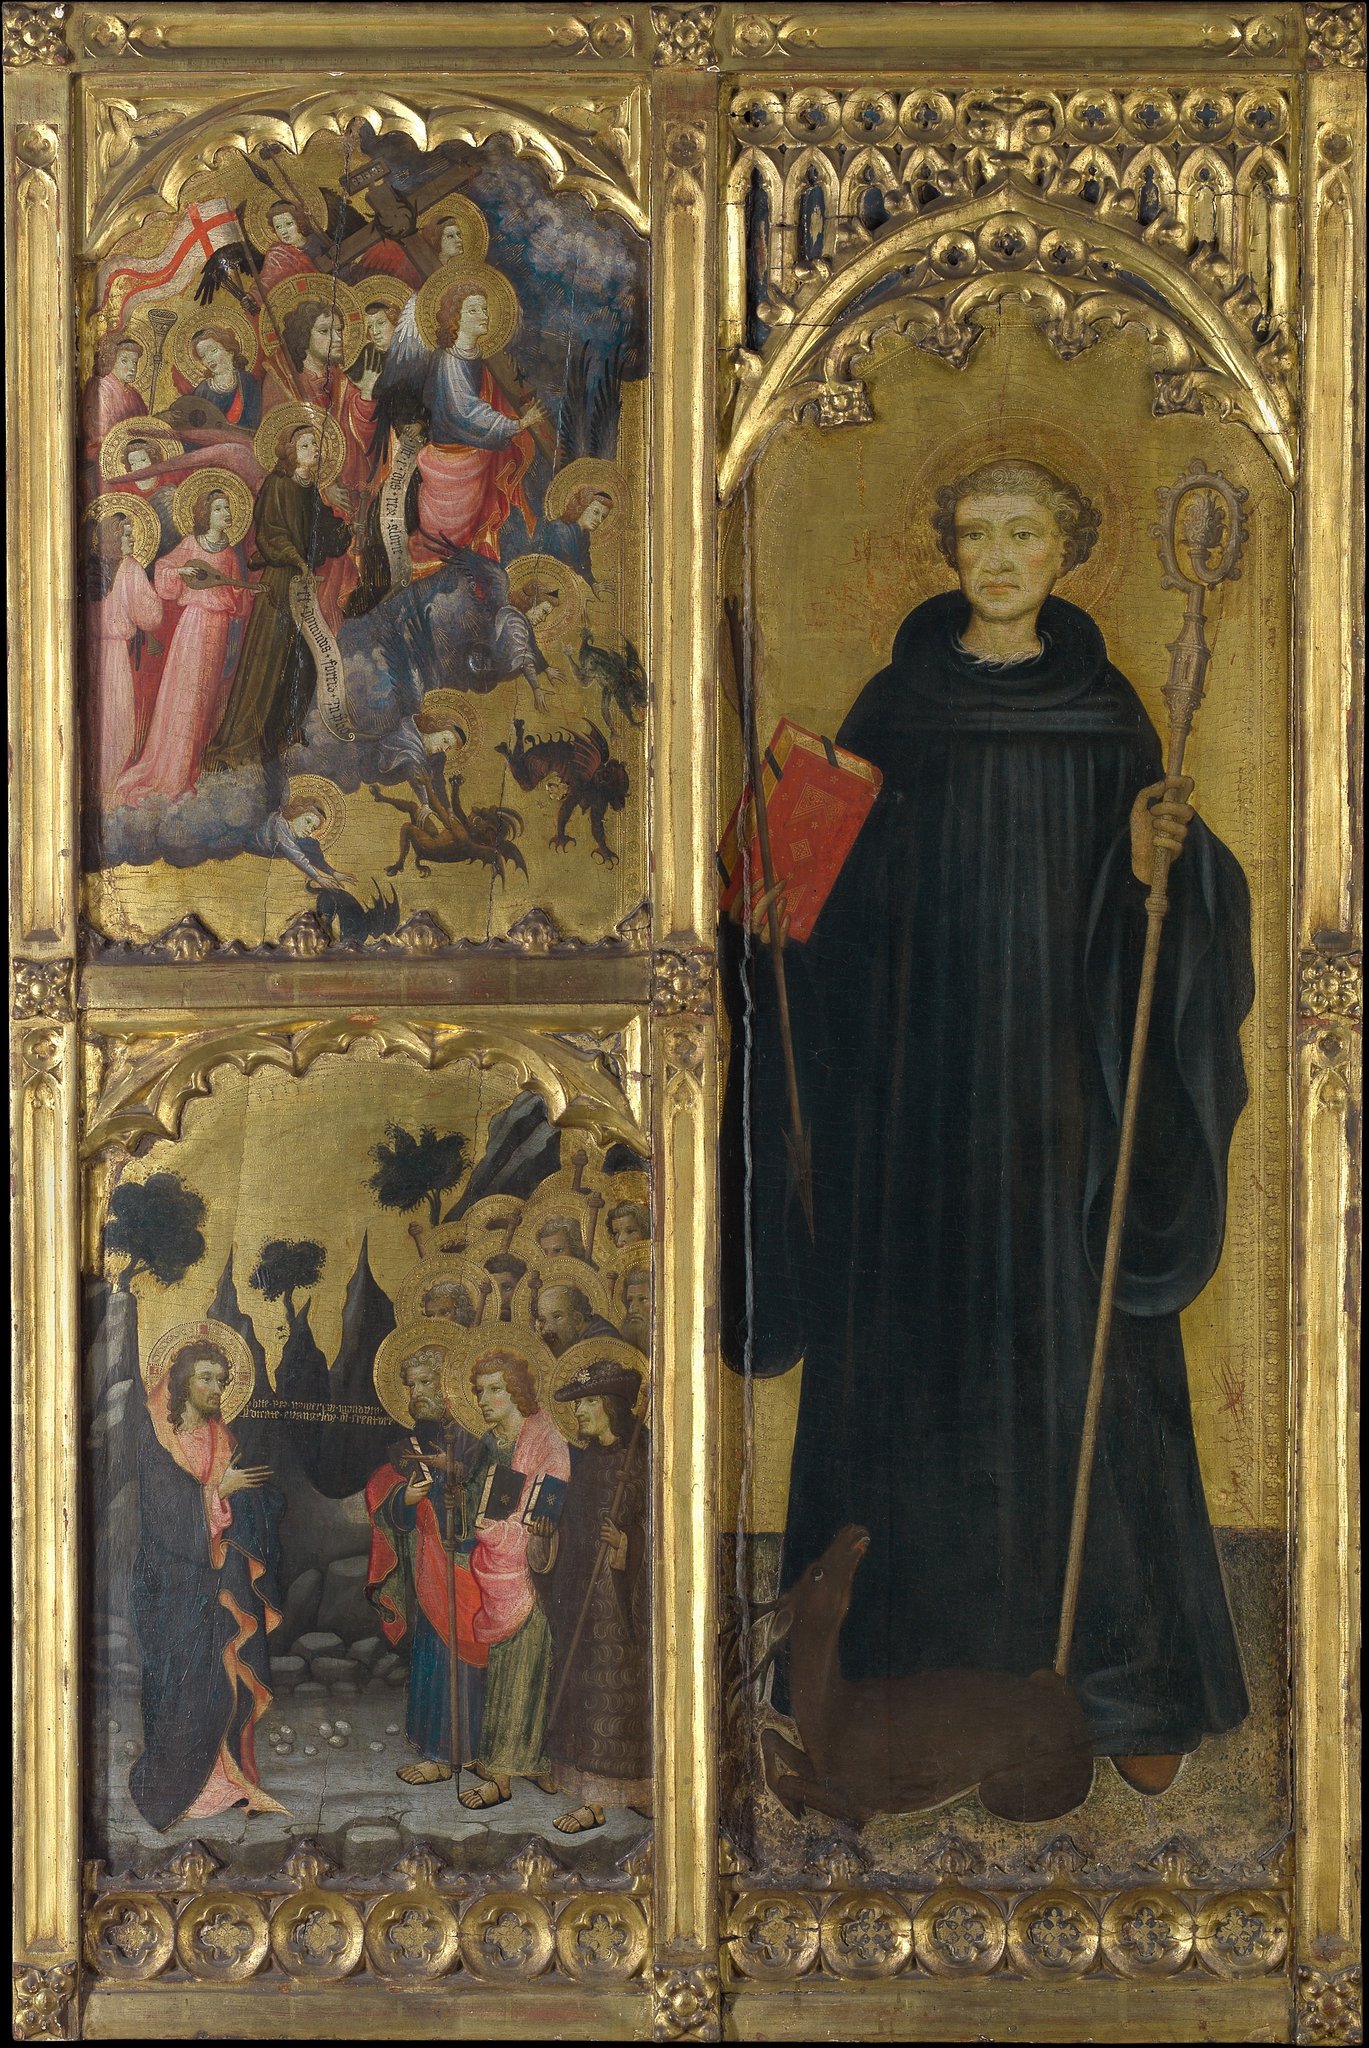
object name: painting, part of an altarpiece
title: Saint Giles with Christ Triumphant over Satan and the Mission of the Apostles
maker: miguel alcañiz (or miquel alcanyís)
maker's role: artist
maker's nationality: spanish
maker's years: 1408-1447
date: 1408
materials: gold leaf, paint, wood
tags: apostles,christ,saints